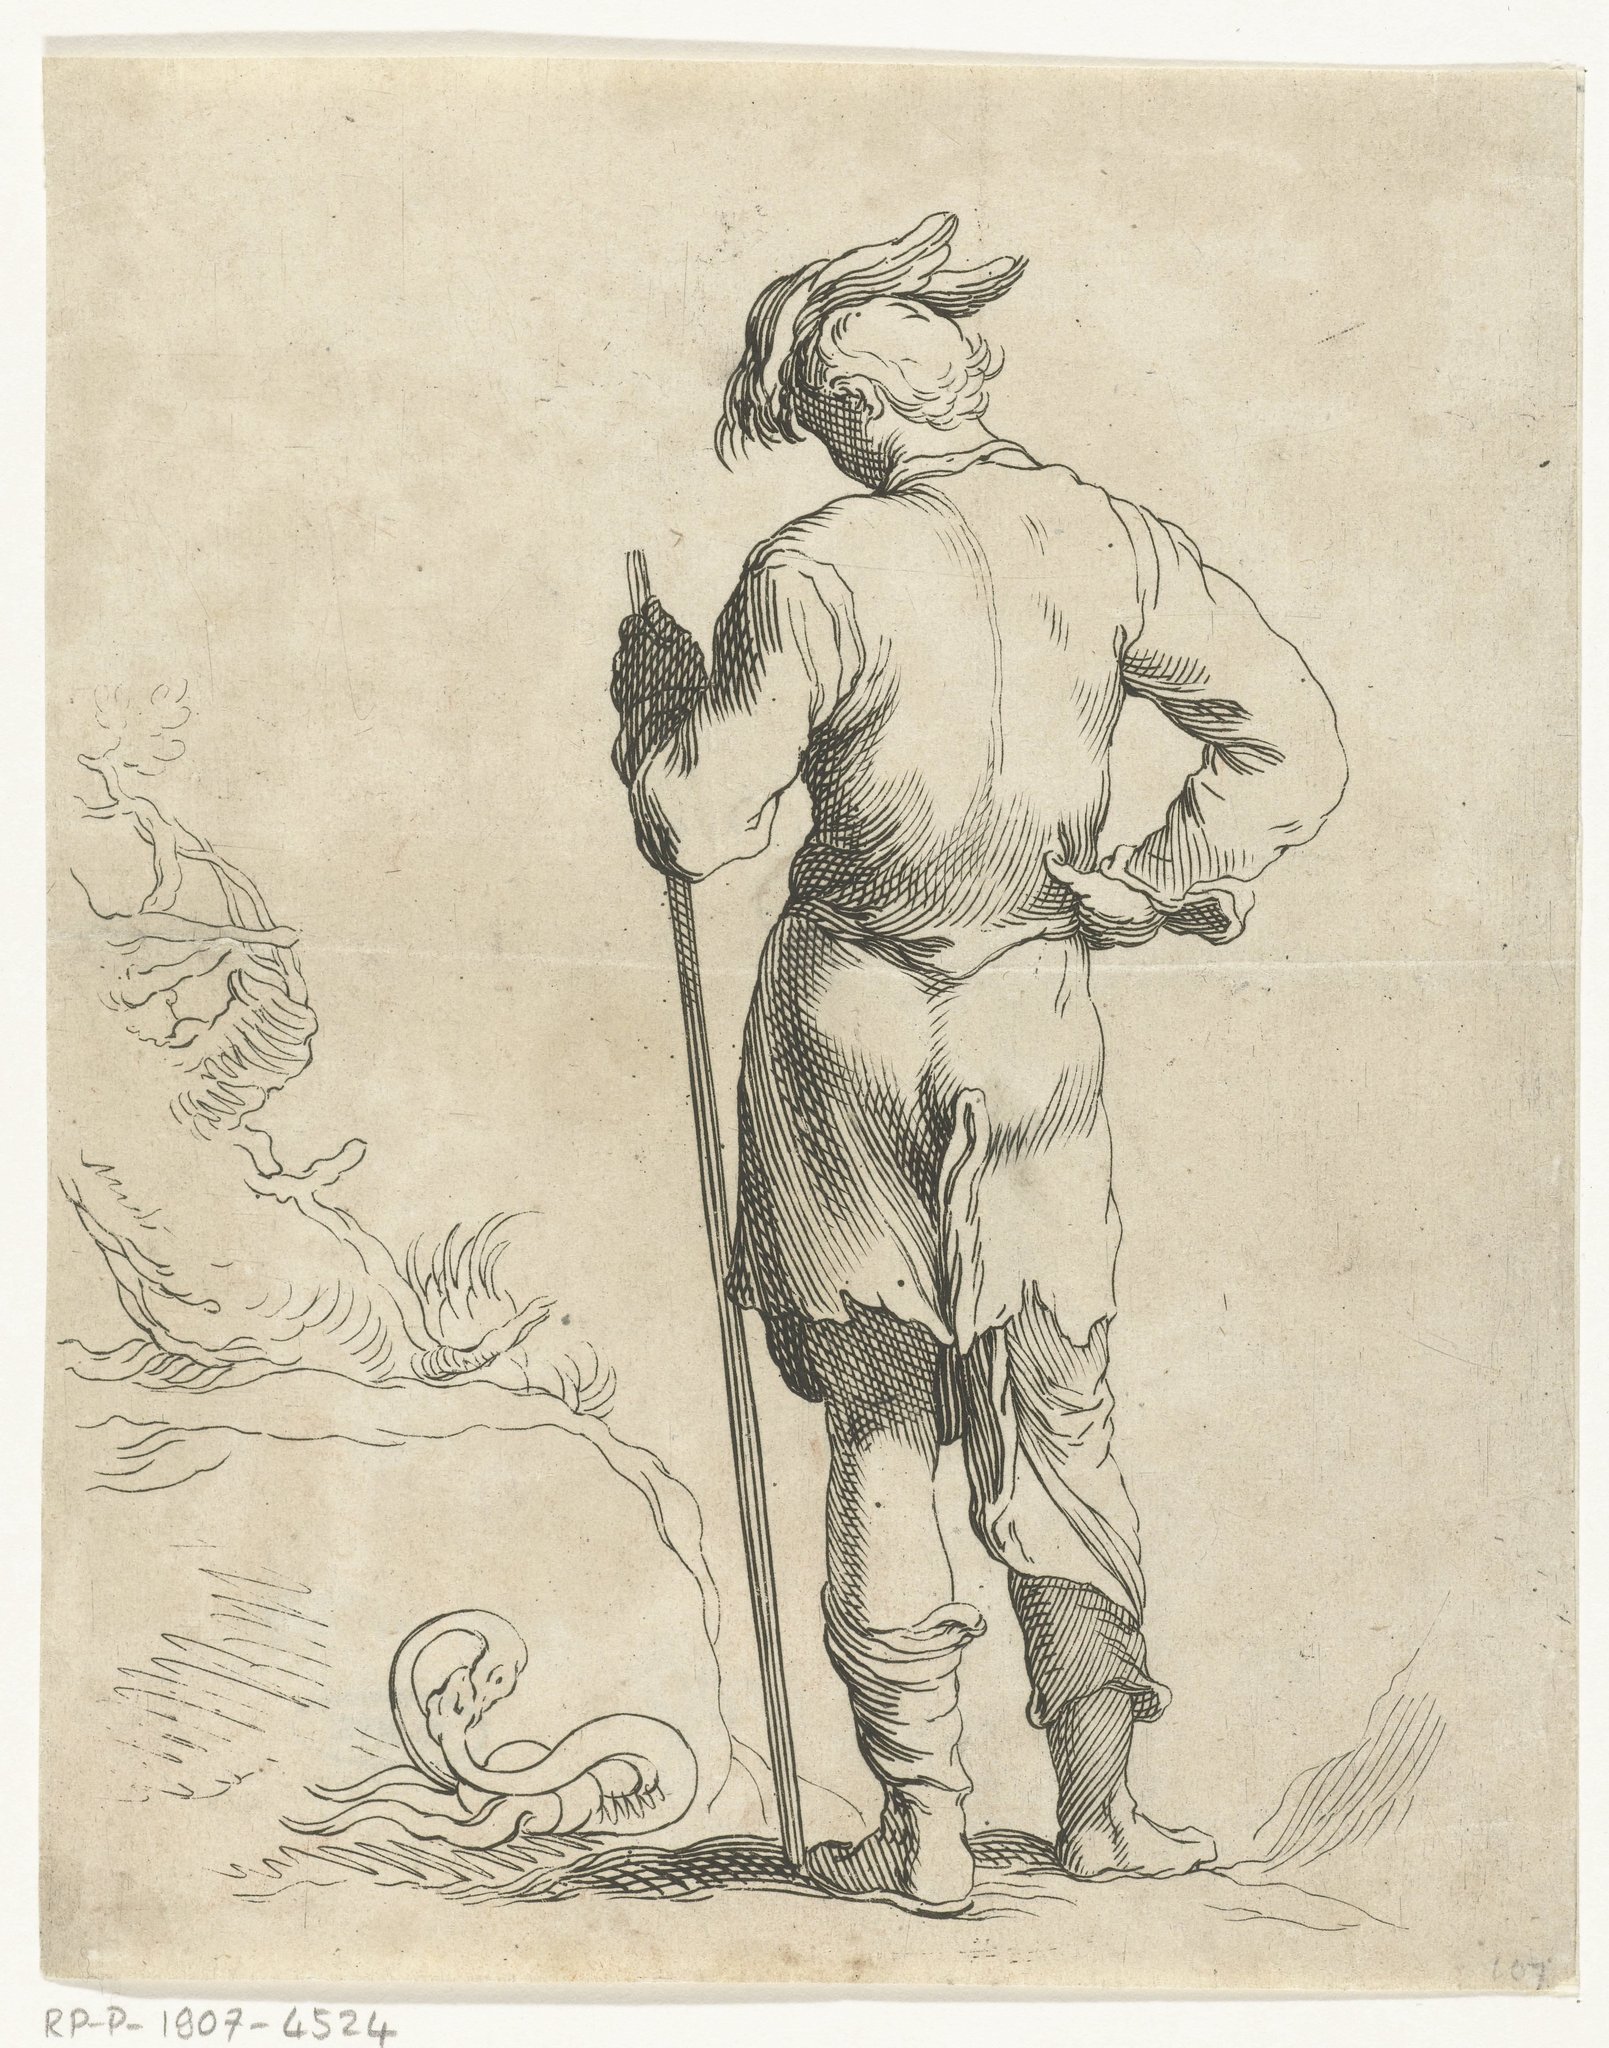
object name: print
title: Het tekenboek van Abraham Bloemaert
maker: frederick bloemaert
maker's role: print maker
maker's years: 1614-1669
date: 1650-1656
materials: paper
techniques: engraving, etching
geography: utrecht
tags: snakes, the (nude) human figure; 'corpo humano' (ripa) (+ standing)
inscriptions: collector's mark: Lugt 2228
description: Een staande man met een pluimhoed op, op de rug gezien. De man kijkt naar twee vechtende slangen op de grond.